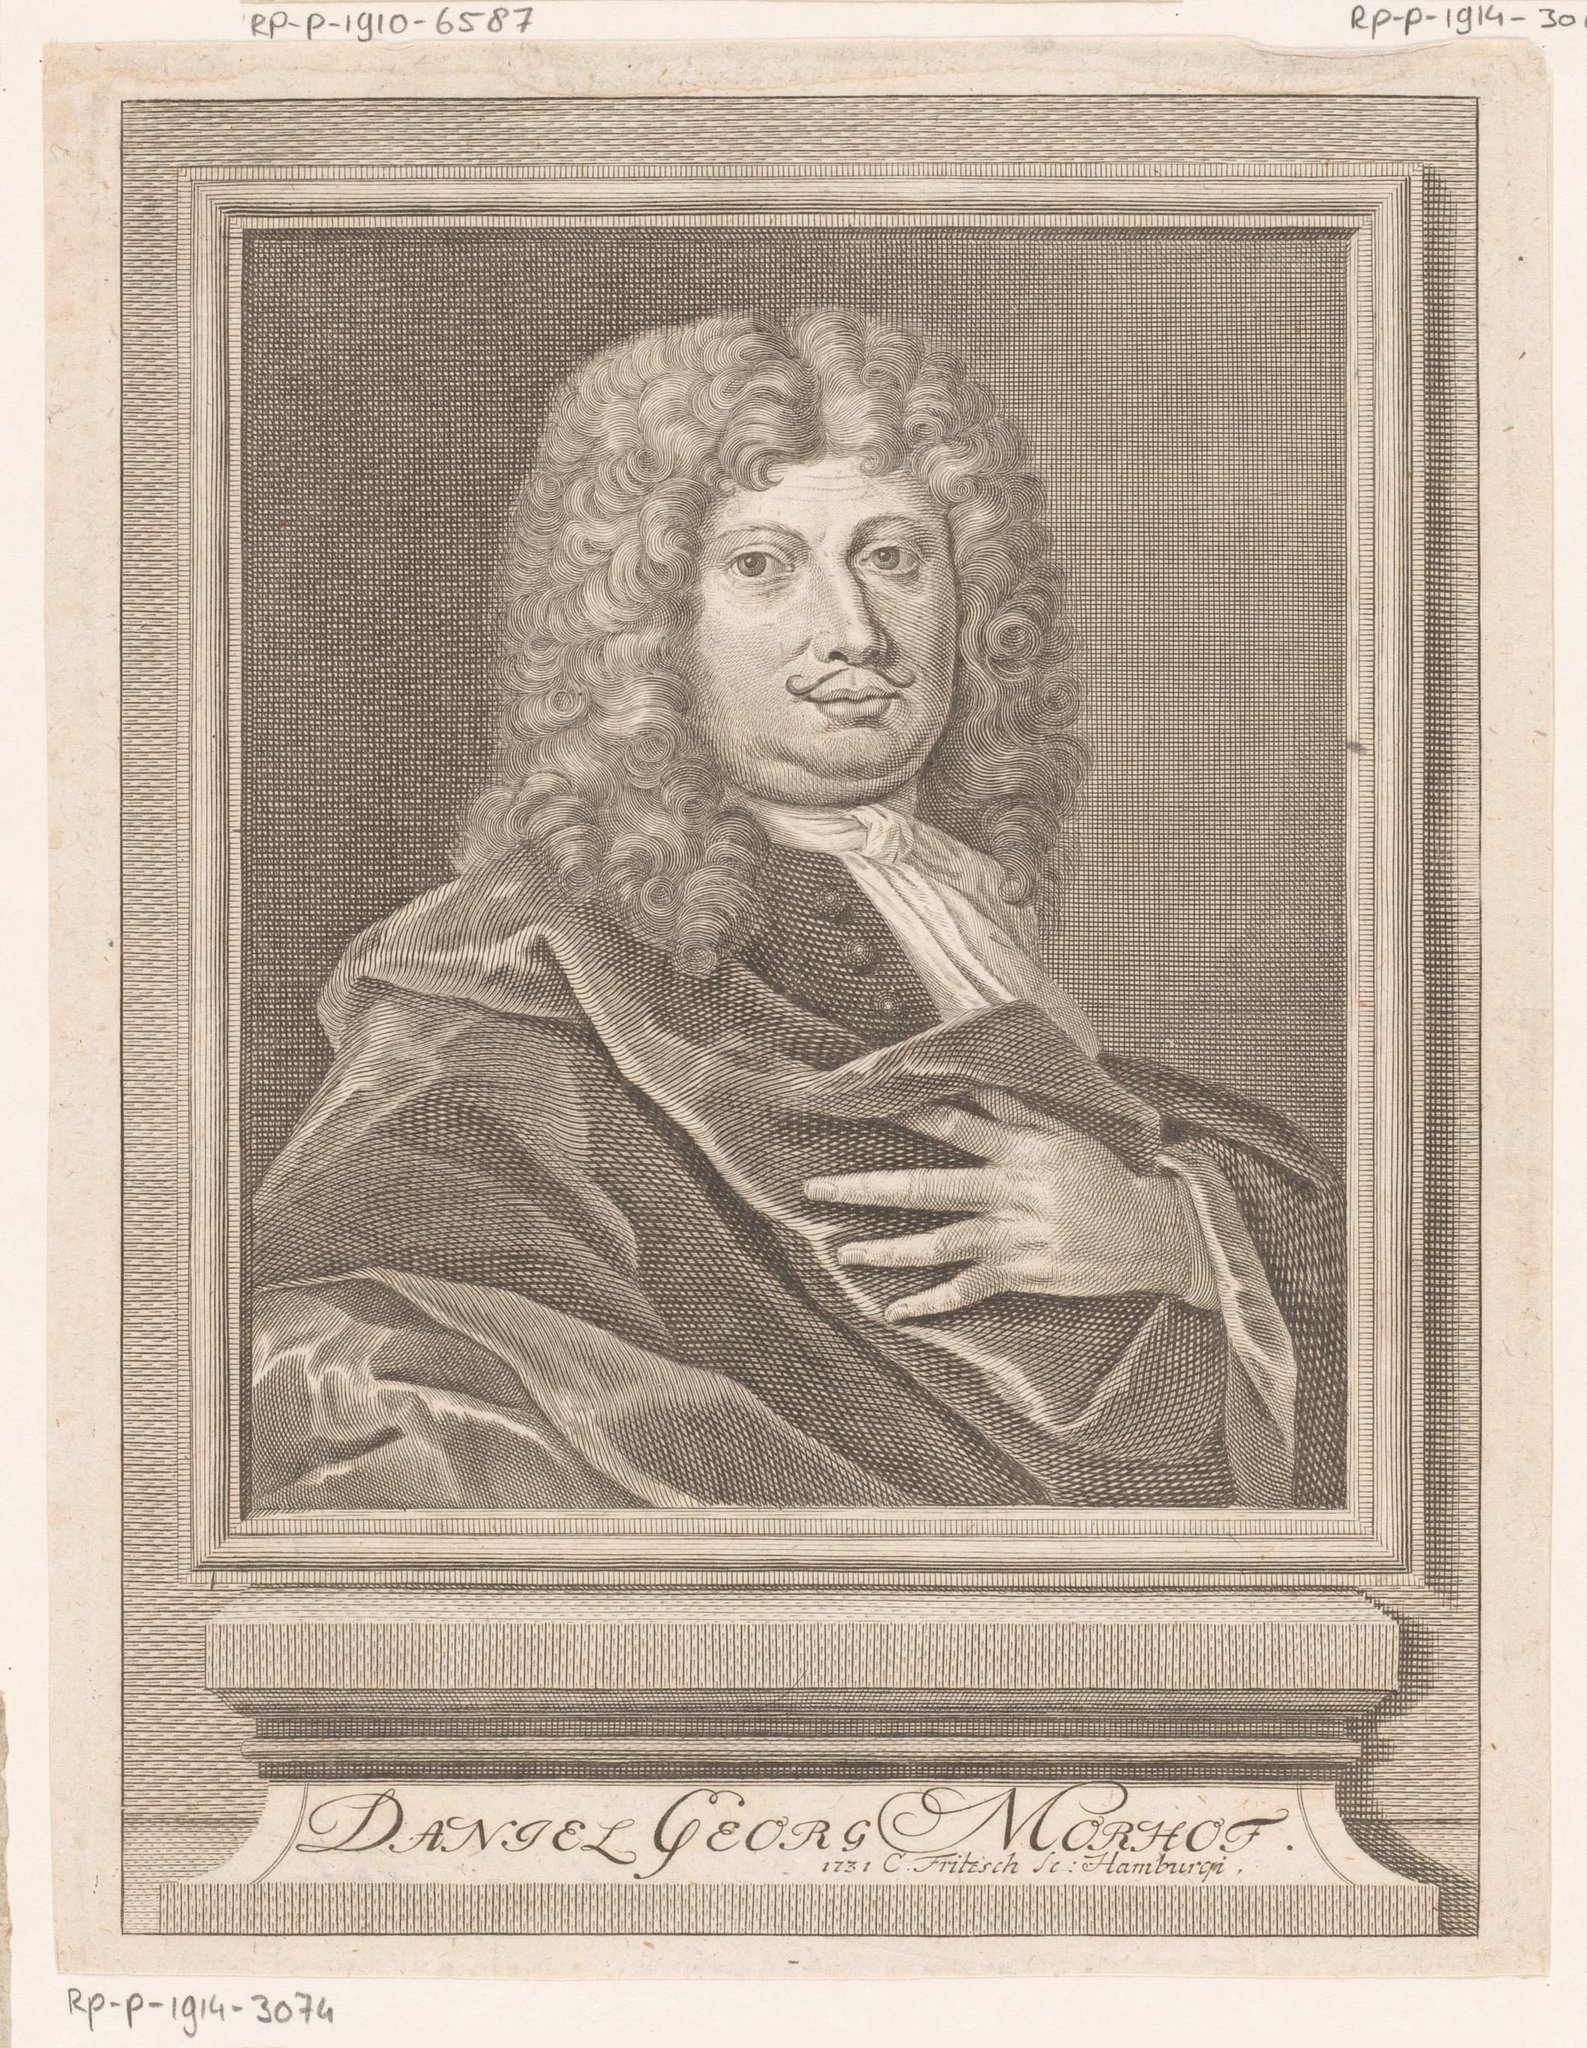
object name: print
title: Portret van Daniel Georg Morhof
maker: christian fritzsch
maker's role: print maker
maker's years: 1695-1769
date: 1731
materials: paper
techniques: engraving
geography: hamburg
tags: daniel georg morhof, historical persons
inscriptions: collector's mark: Lugt 2228